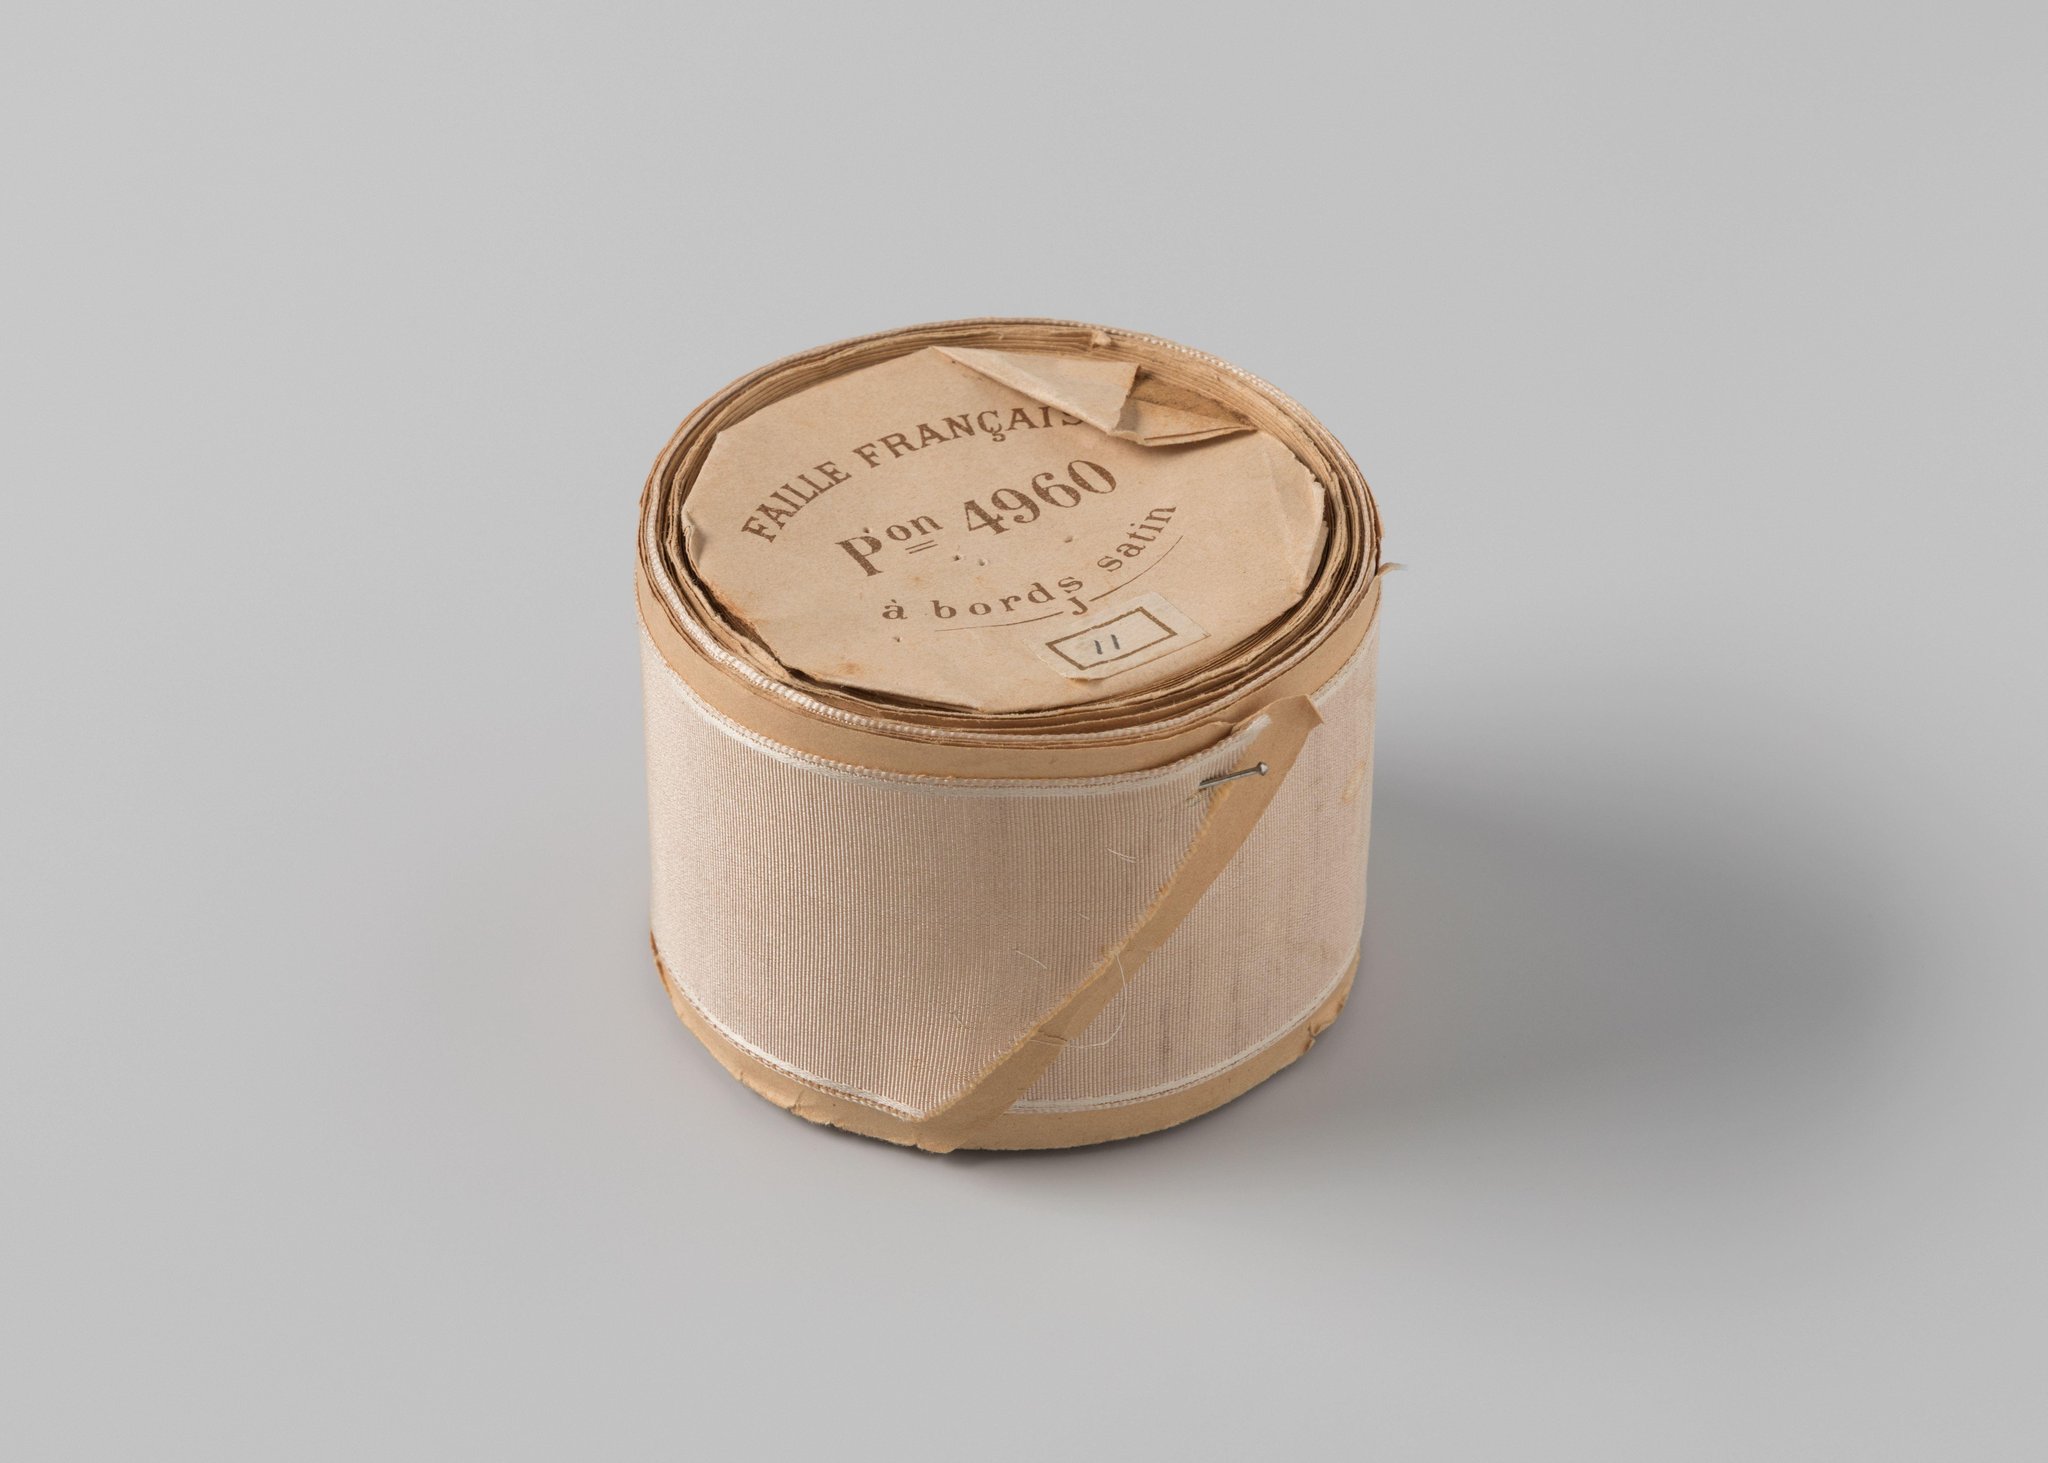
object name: ribbon material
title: Rol met crème zijden satijnlint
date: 1925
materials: cardboard, silk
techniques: satin binding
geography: nijmegen